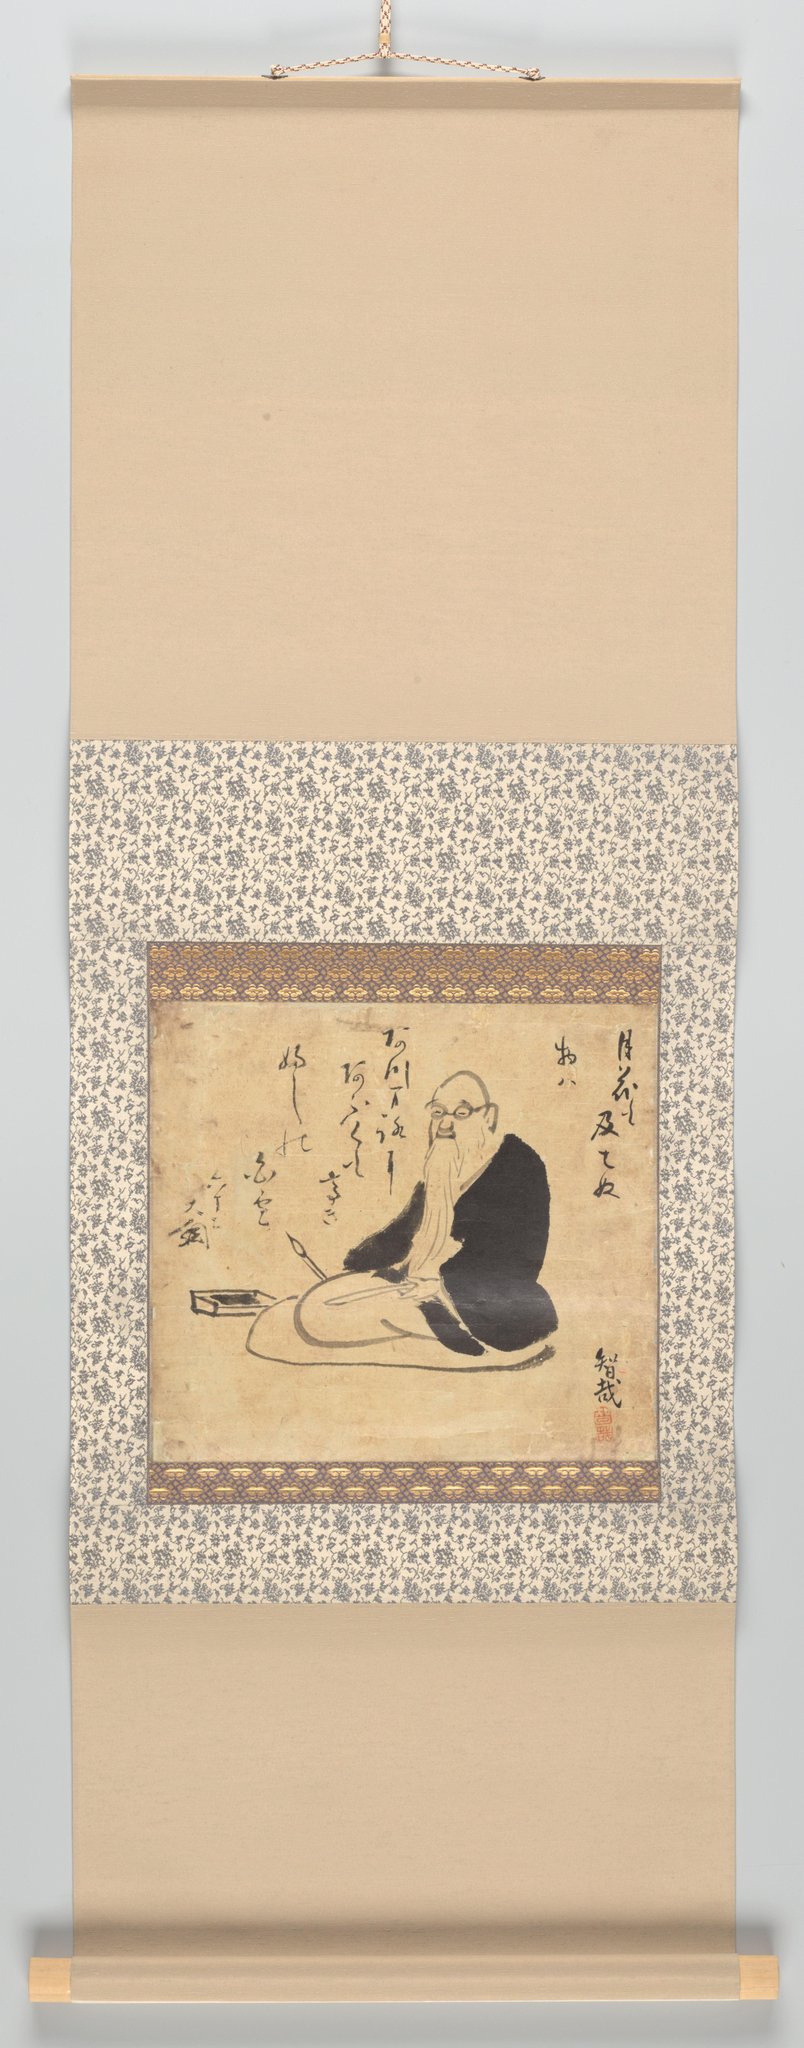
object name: hanging scroll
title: Zen-schildering en kalligrafie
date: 1772-1860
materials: ink, paper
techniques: calligraphy